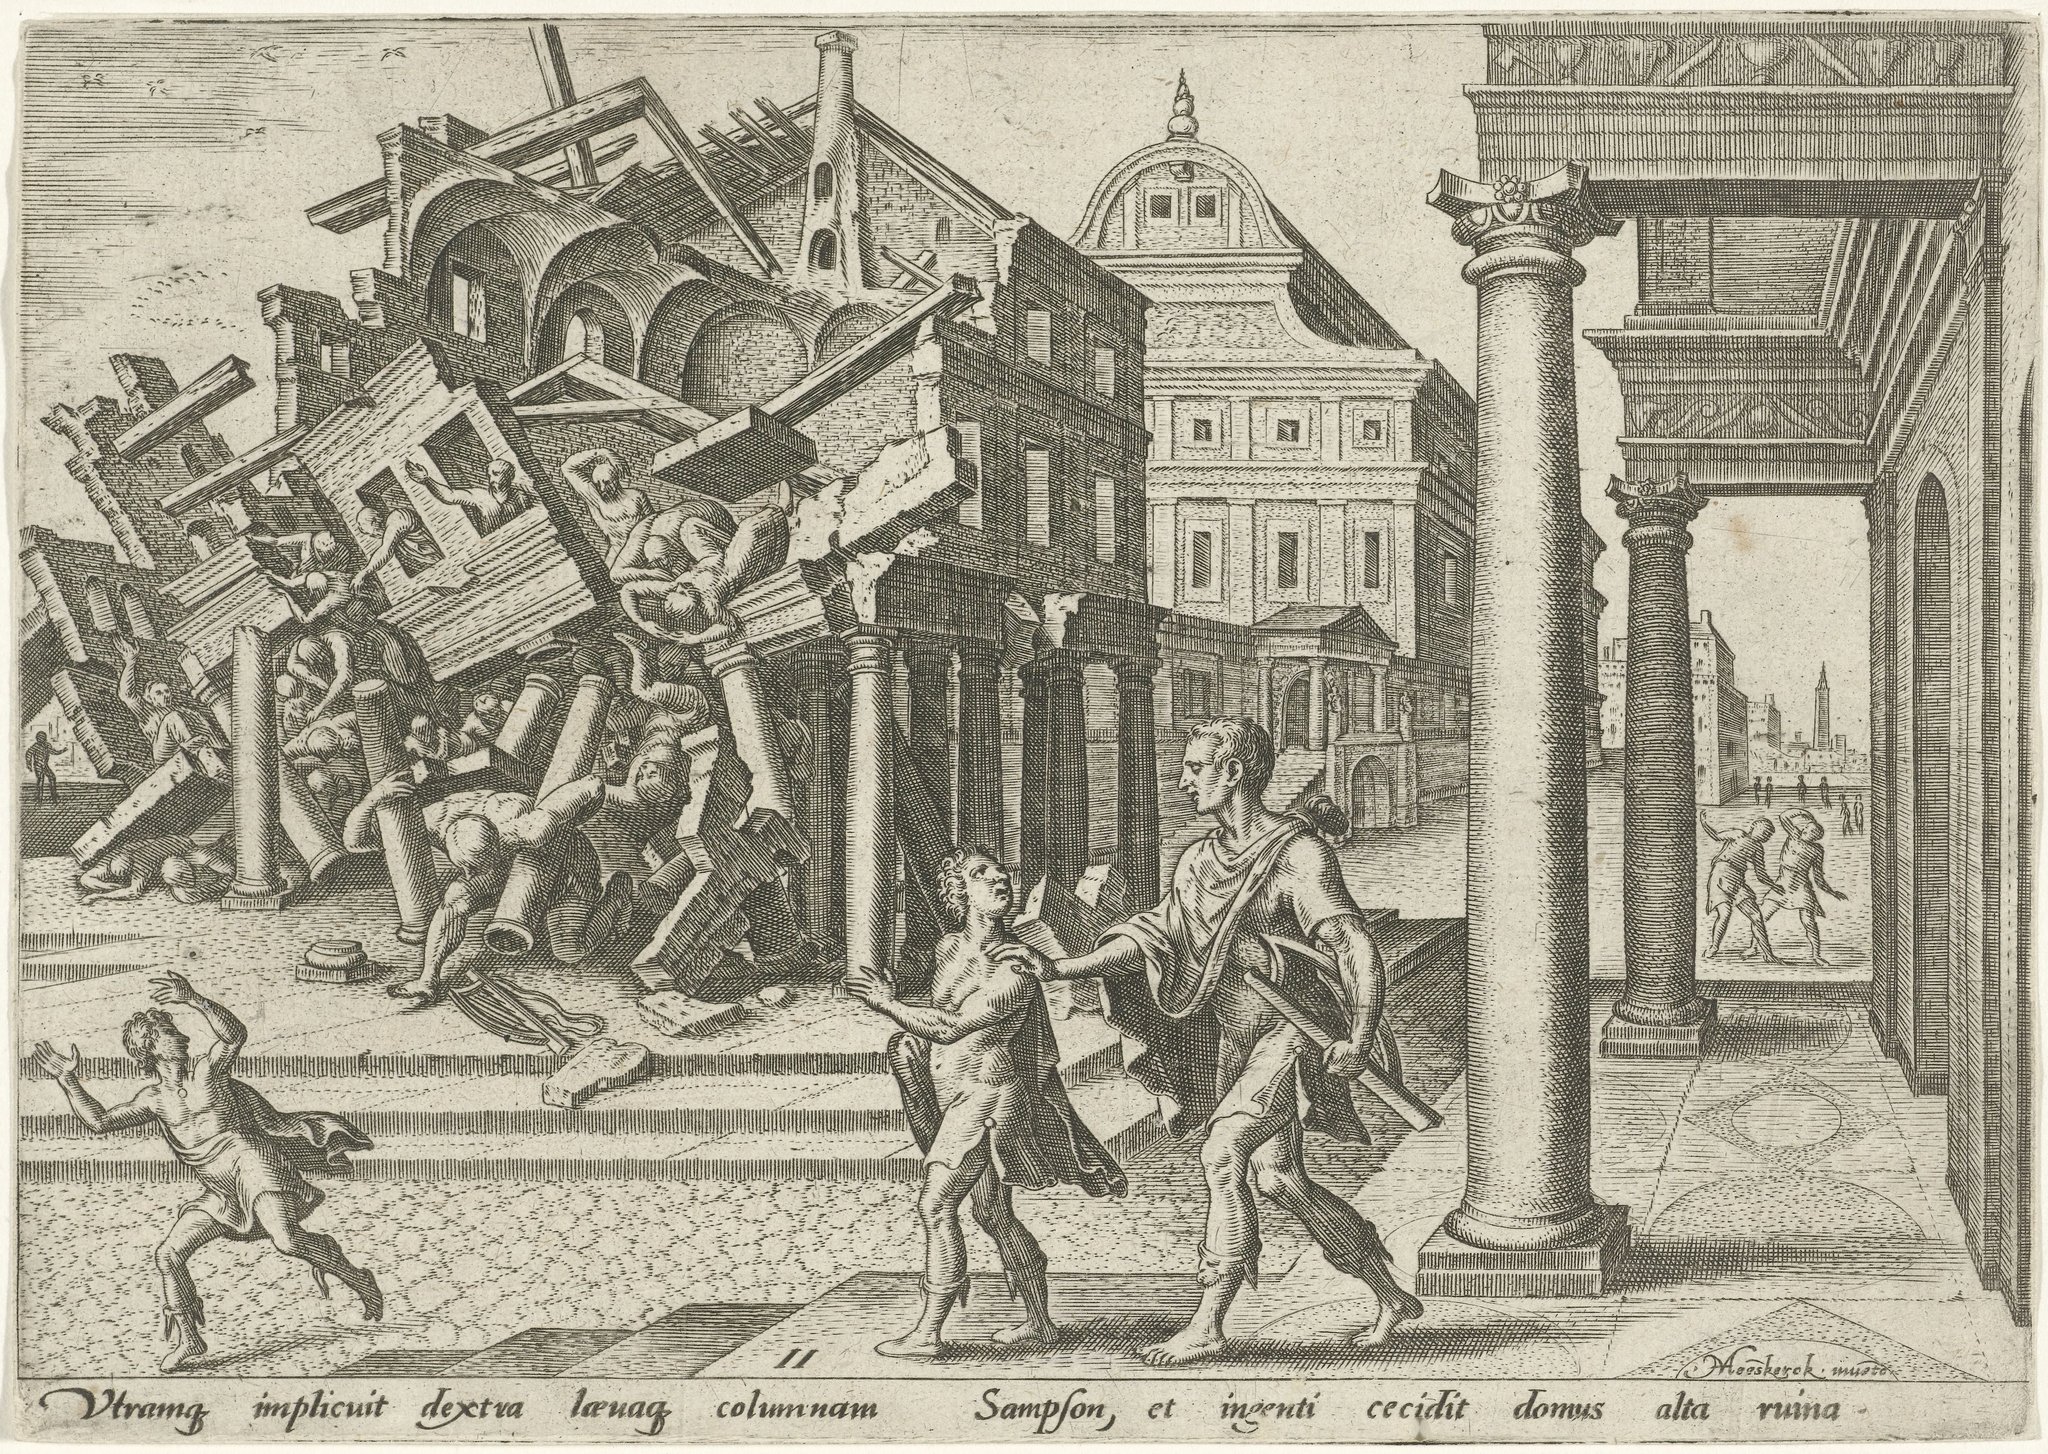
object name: print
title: Simson verwoest de tempel van de Filistijnen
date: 1569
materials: paper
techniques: engraving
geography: haarlem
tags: samson breaks the pillars; the temple of dagon collapses, killing all that are in it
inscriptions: number: ‘11’, caption: ‘Vtramq[ue] implicuit dextra laeuaq[ue] columnam / Sampson, et ingenti cecidit domus alta ruina.’, signature: ‘MHee[m]skerck inve[n]tor’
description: Simson is uit de gevangenis bevrijd en verwoest de tempel van de Filistijnen door met twee zuilen onder zijn armen weg te lopen. Het gebouw valt over hem heen. Rechtsvoor een man met harp (lier) onder zijn arm en een jongen op de trappen van een gebouw met zuilenportiek.